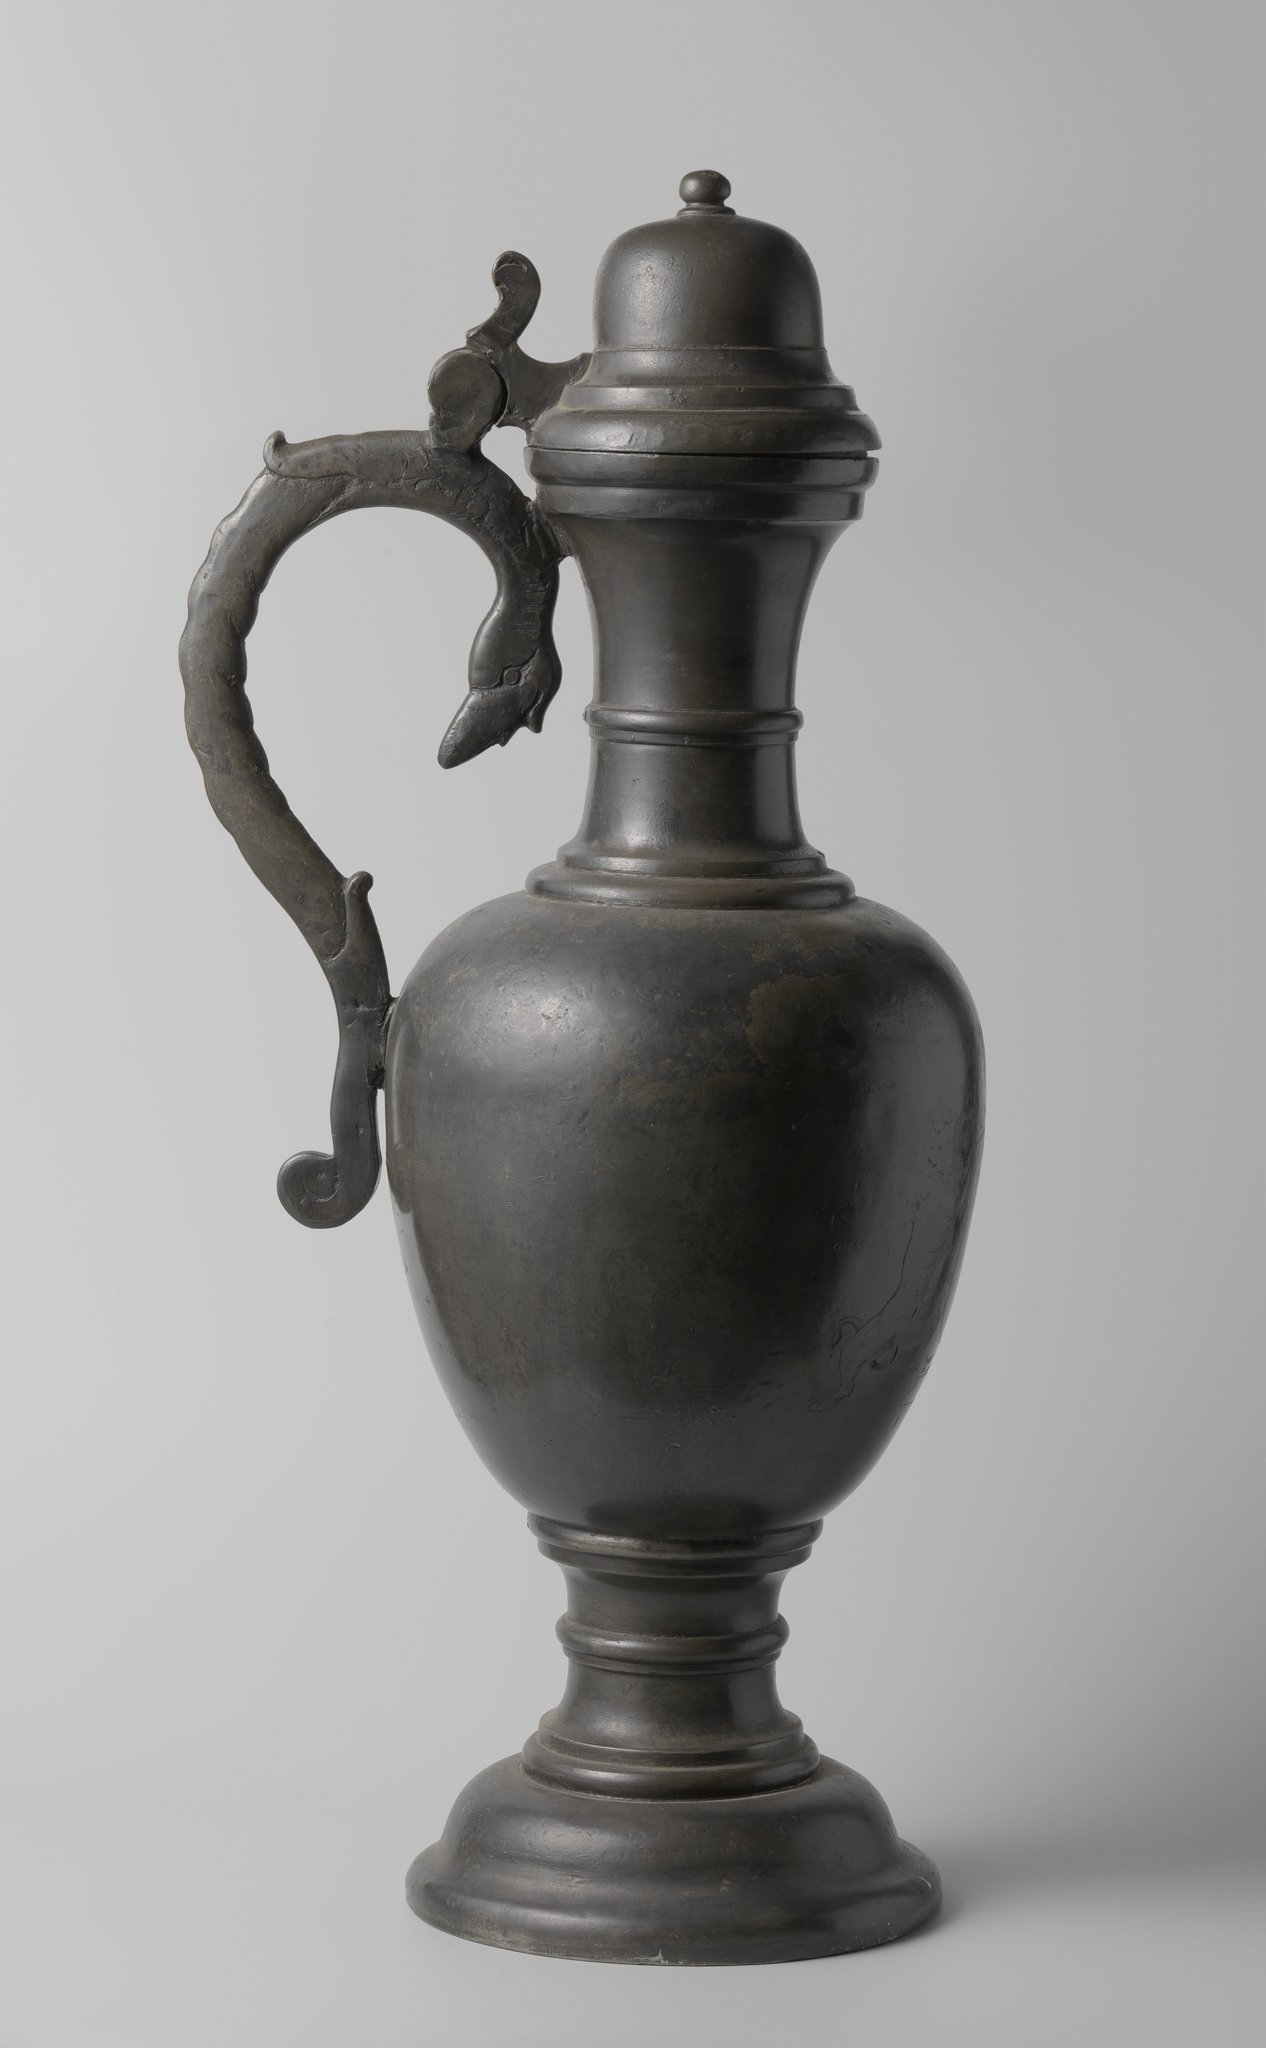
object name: jug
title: Amsterdam City Jug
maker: harmen barendsz. haen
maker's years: 1623-1695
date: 1651-1652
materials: tin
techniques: casting, engraving, turning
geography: amsterdam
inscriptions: coat of arms, quality mark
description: This city jug is one of a series of eight and was designed by the sculptor Artus Quellinus. The escutcheon on the belly features the Amsterdam coat of arms, with an imperial crown. Such jugs were used for special occasions, when they were filled with wine and handed around to the important visitors and members of the town council.